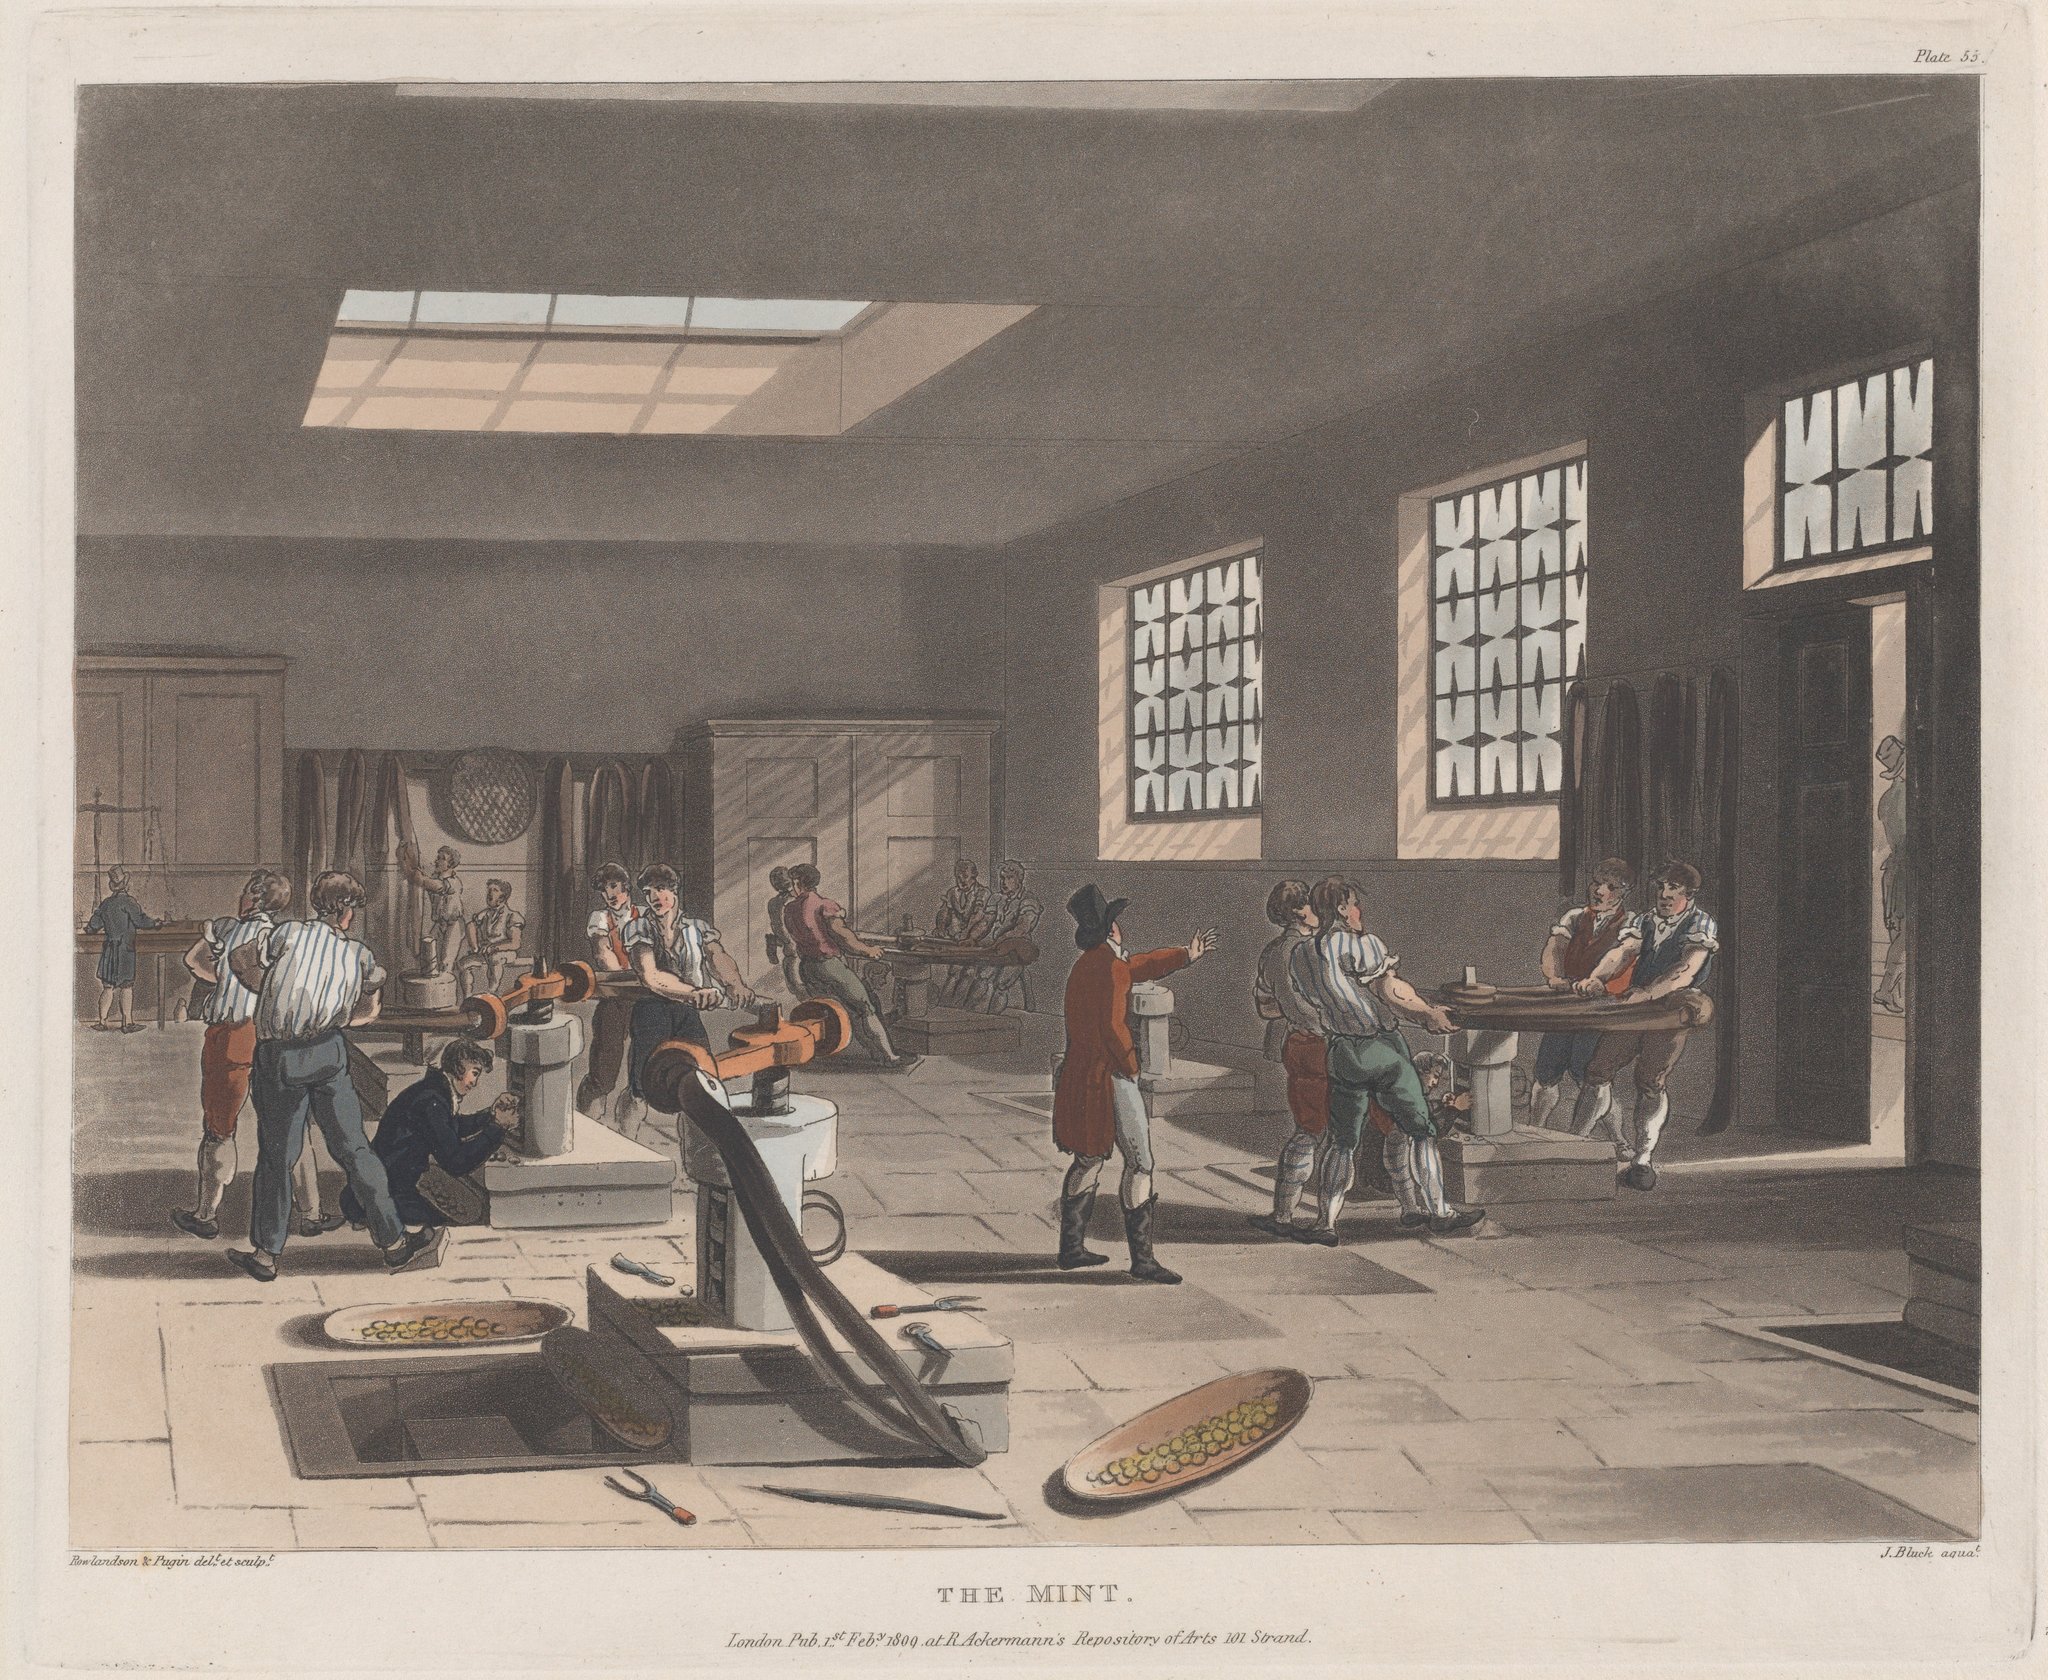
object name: print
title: The Mint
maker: thomas rowlandson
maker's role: artist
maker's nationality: british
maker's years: 1757-1827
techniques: aquatint, etching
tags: interiors,men,working,coins,money,industry